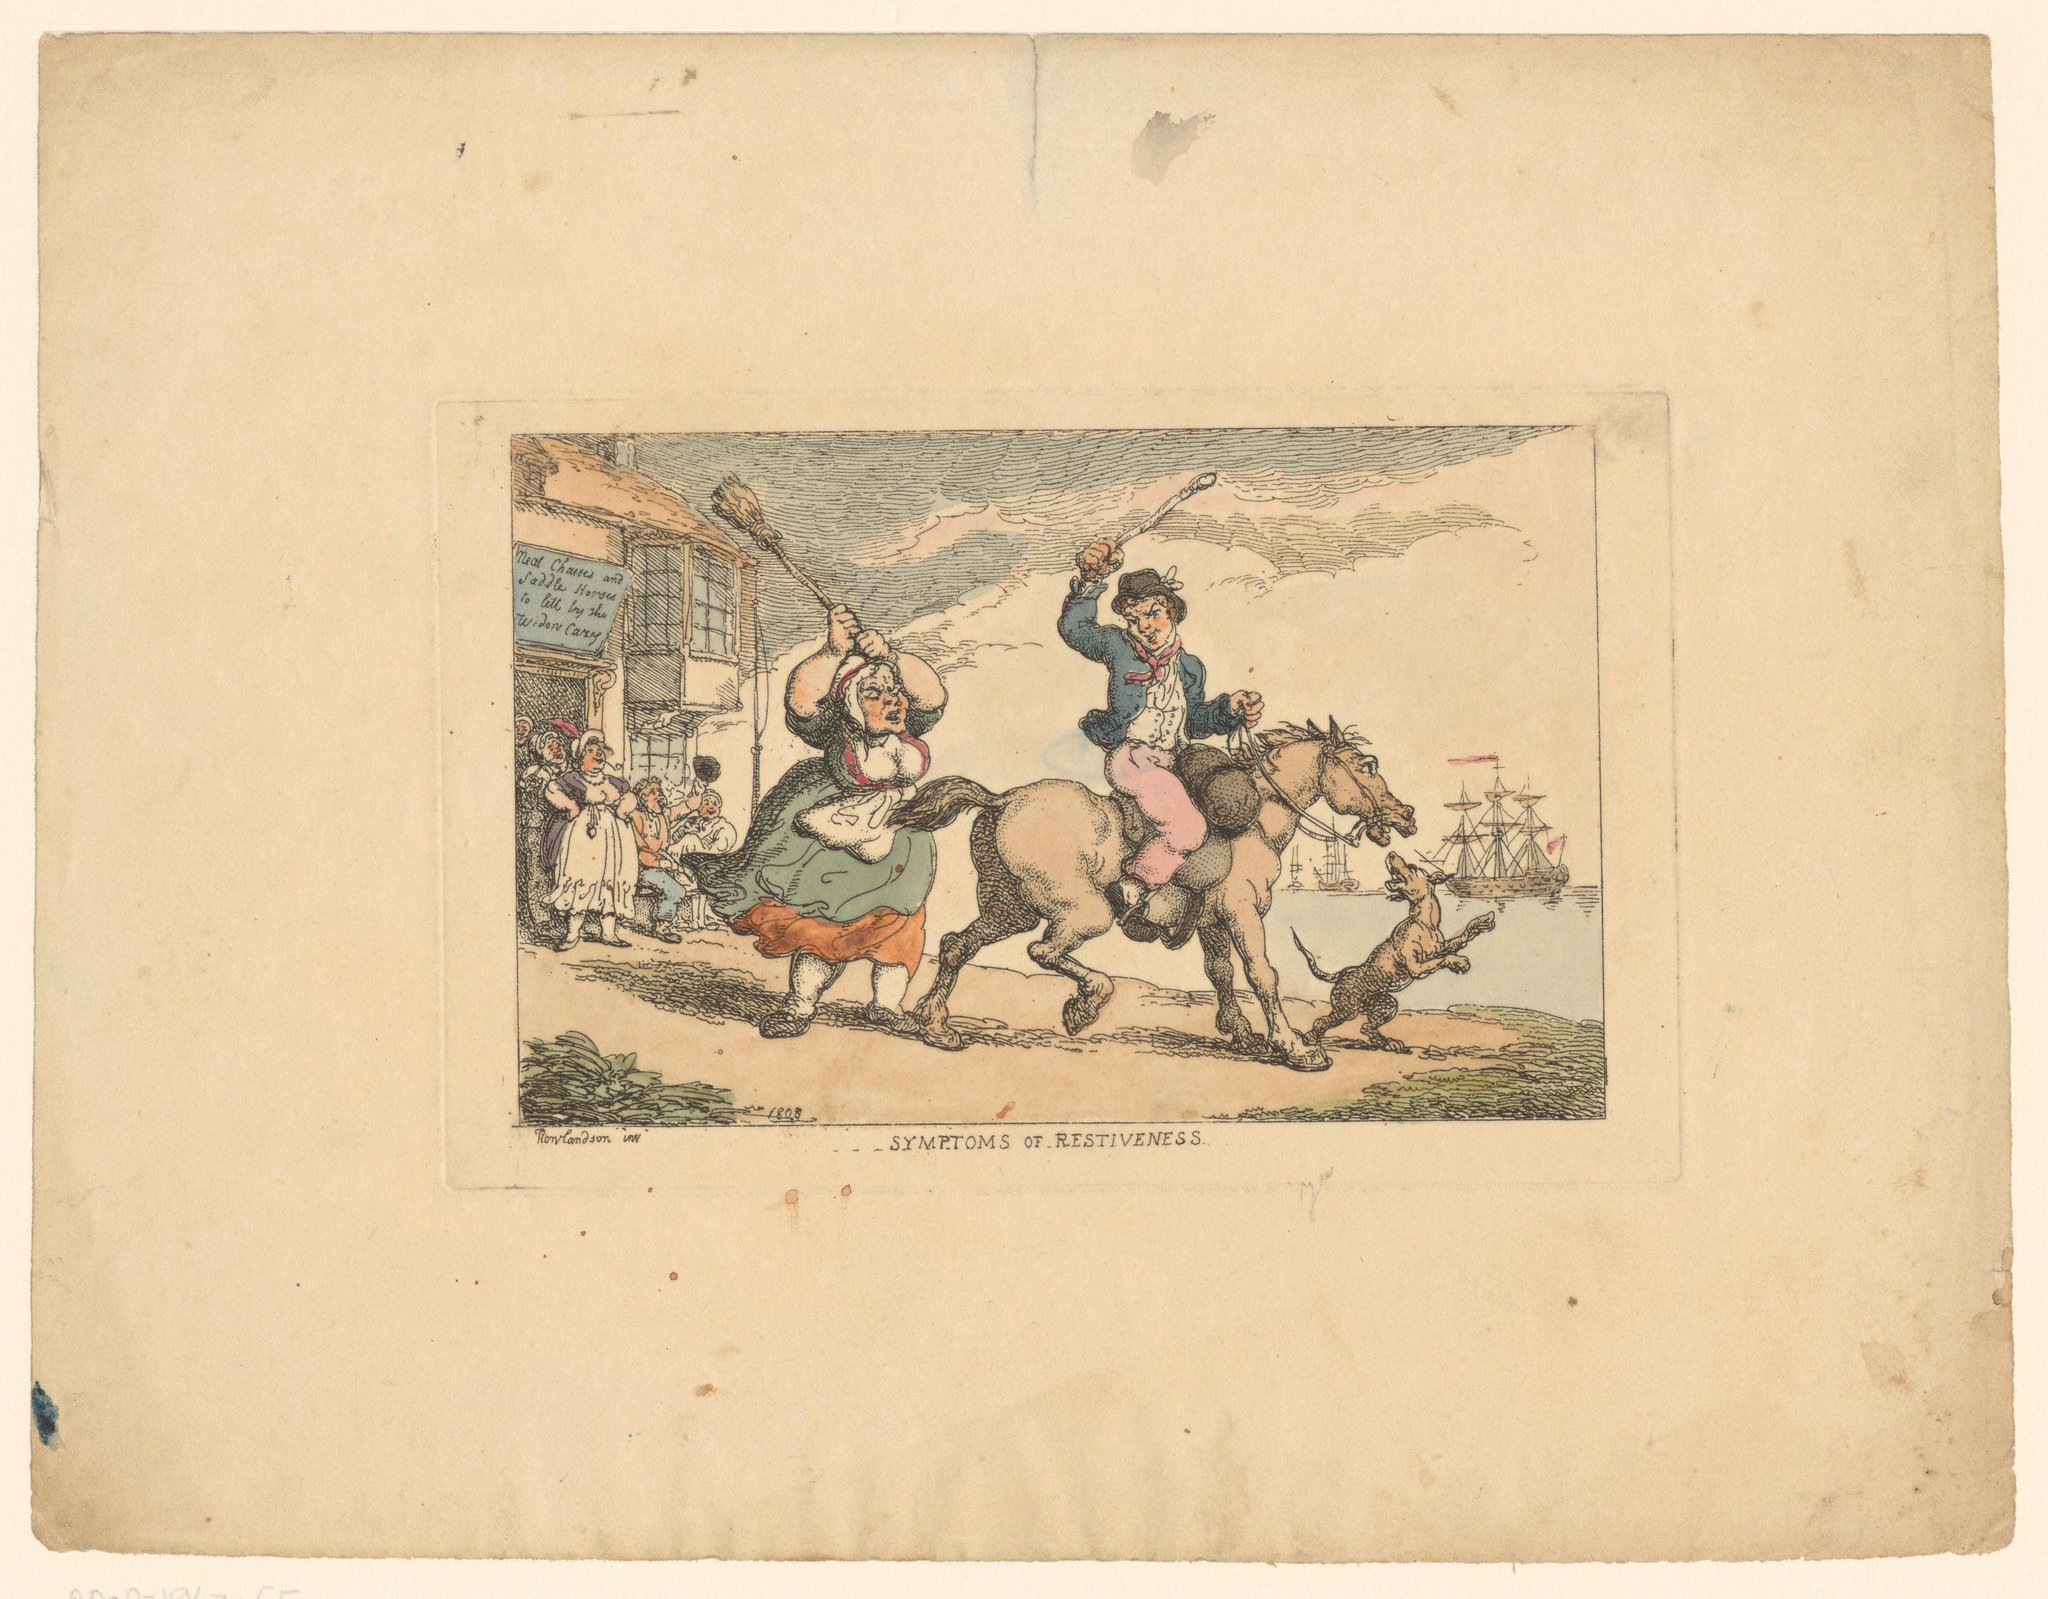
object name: print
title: Vrouw jaagt man te paard weg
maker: thomas rowlandson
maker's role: draughtsman, print maker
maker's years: 1756-1827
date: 1808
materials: paper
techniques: etching, hand coloring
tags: misery; 'miseria mondana' (ripa)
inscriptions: collector's mark: Lugt 2760, collector's mark: Lugt 2228